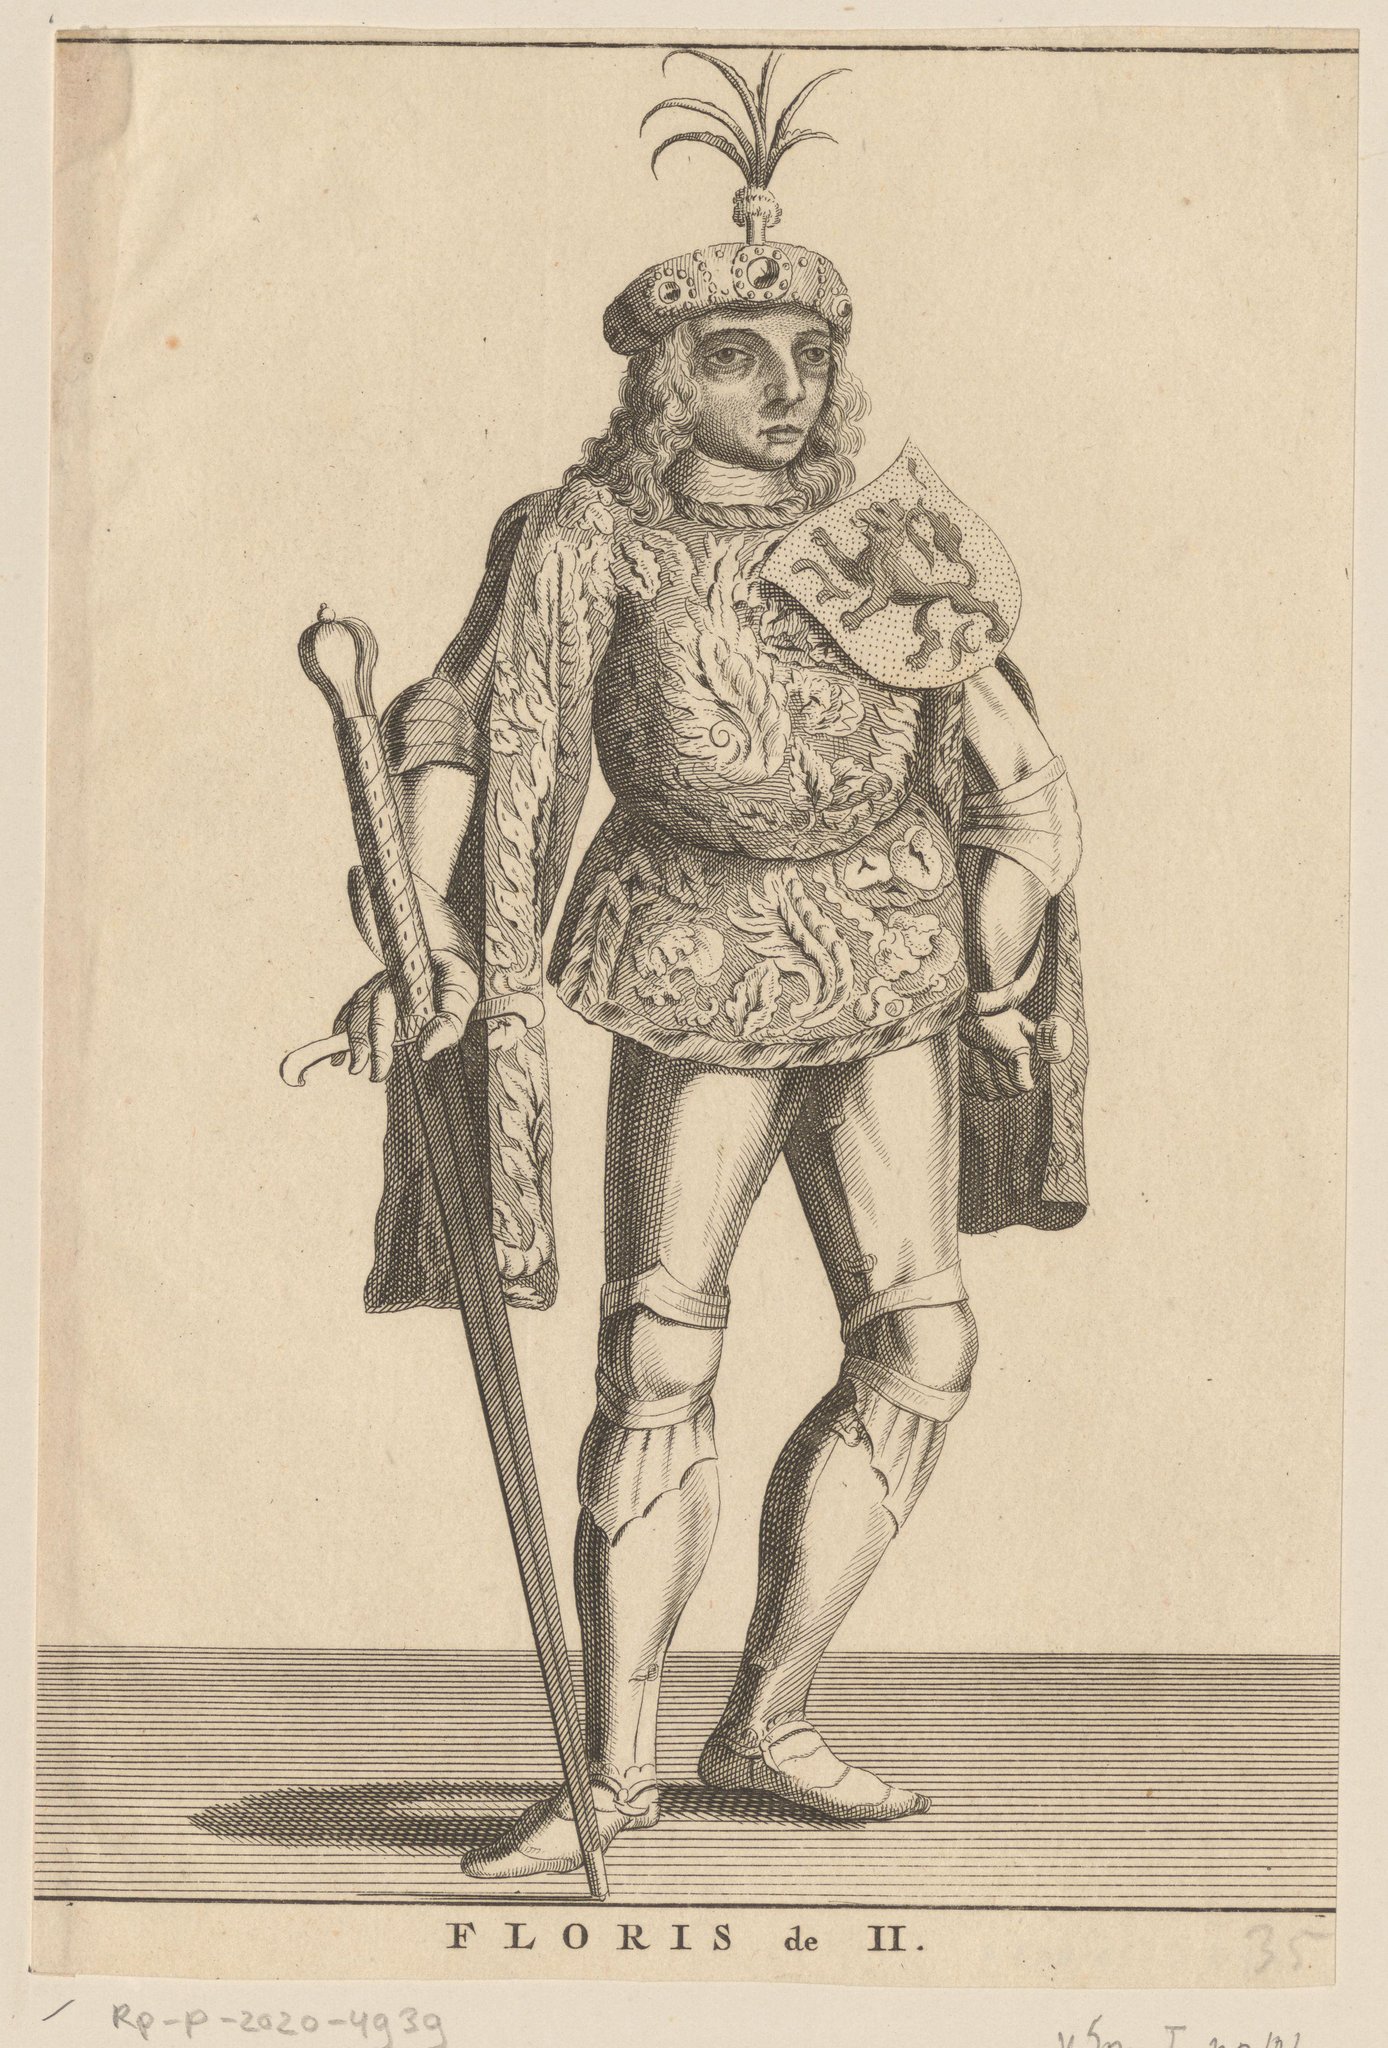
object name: print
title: Portret van Floris II, graaf van Holland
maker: Anonymous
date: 1699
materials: paper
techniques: etching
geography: northern netherlands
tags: floris ii (count of holland), armour, historical persons, ruler, sovereign, armorial bearing, heraldry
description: Prent waarschijnlijk uit: Stoke, Melis. Hollandse jaar-boeken of rijm-kronijk van Melis Stoke. Behelsende de geschiedenissen des lands (...). Leiden: Johannes du Vivié en Isaak Severinus, 1699. Latere staat gebruikt in: Halma, François. Tooneel der Vereenigde Nederlanden, en onderhorige landschappen (...). 2 dln. Leeuwarden: Hendrik Halma, 1725, dl. 1. Derde staat zonder paginanummering gebruikt in 'Korte leevensschets (...)', 1744.